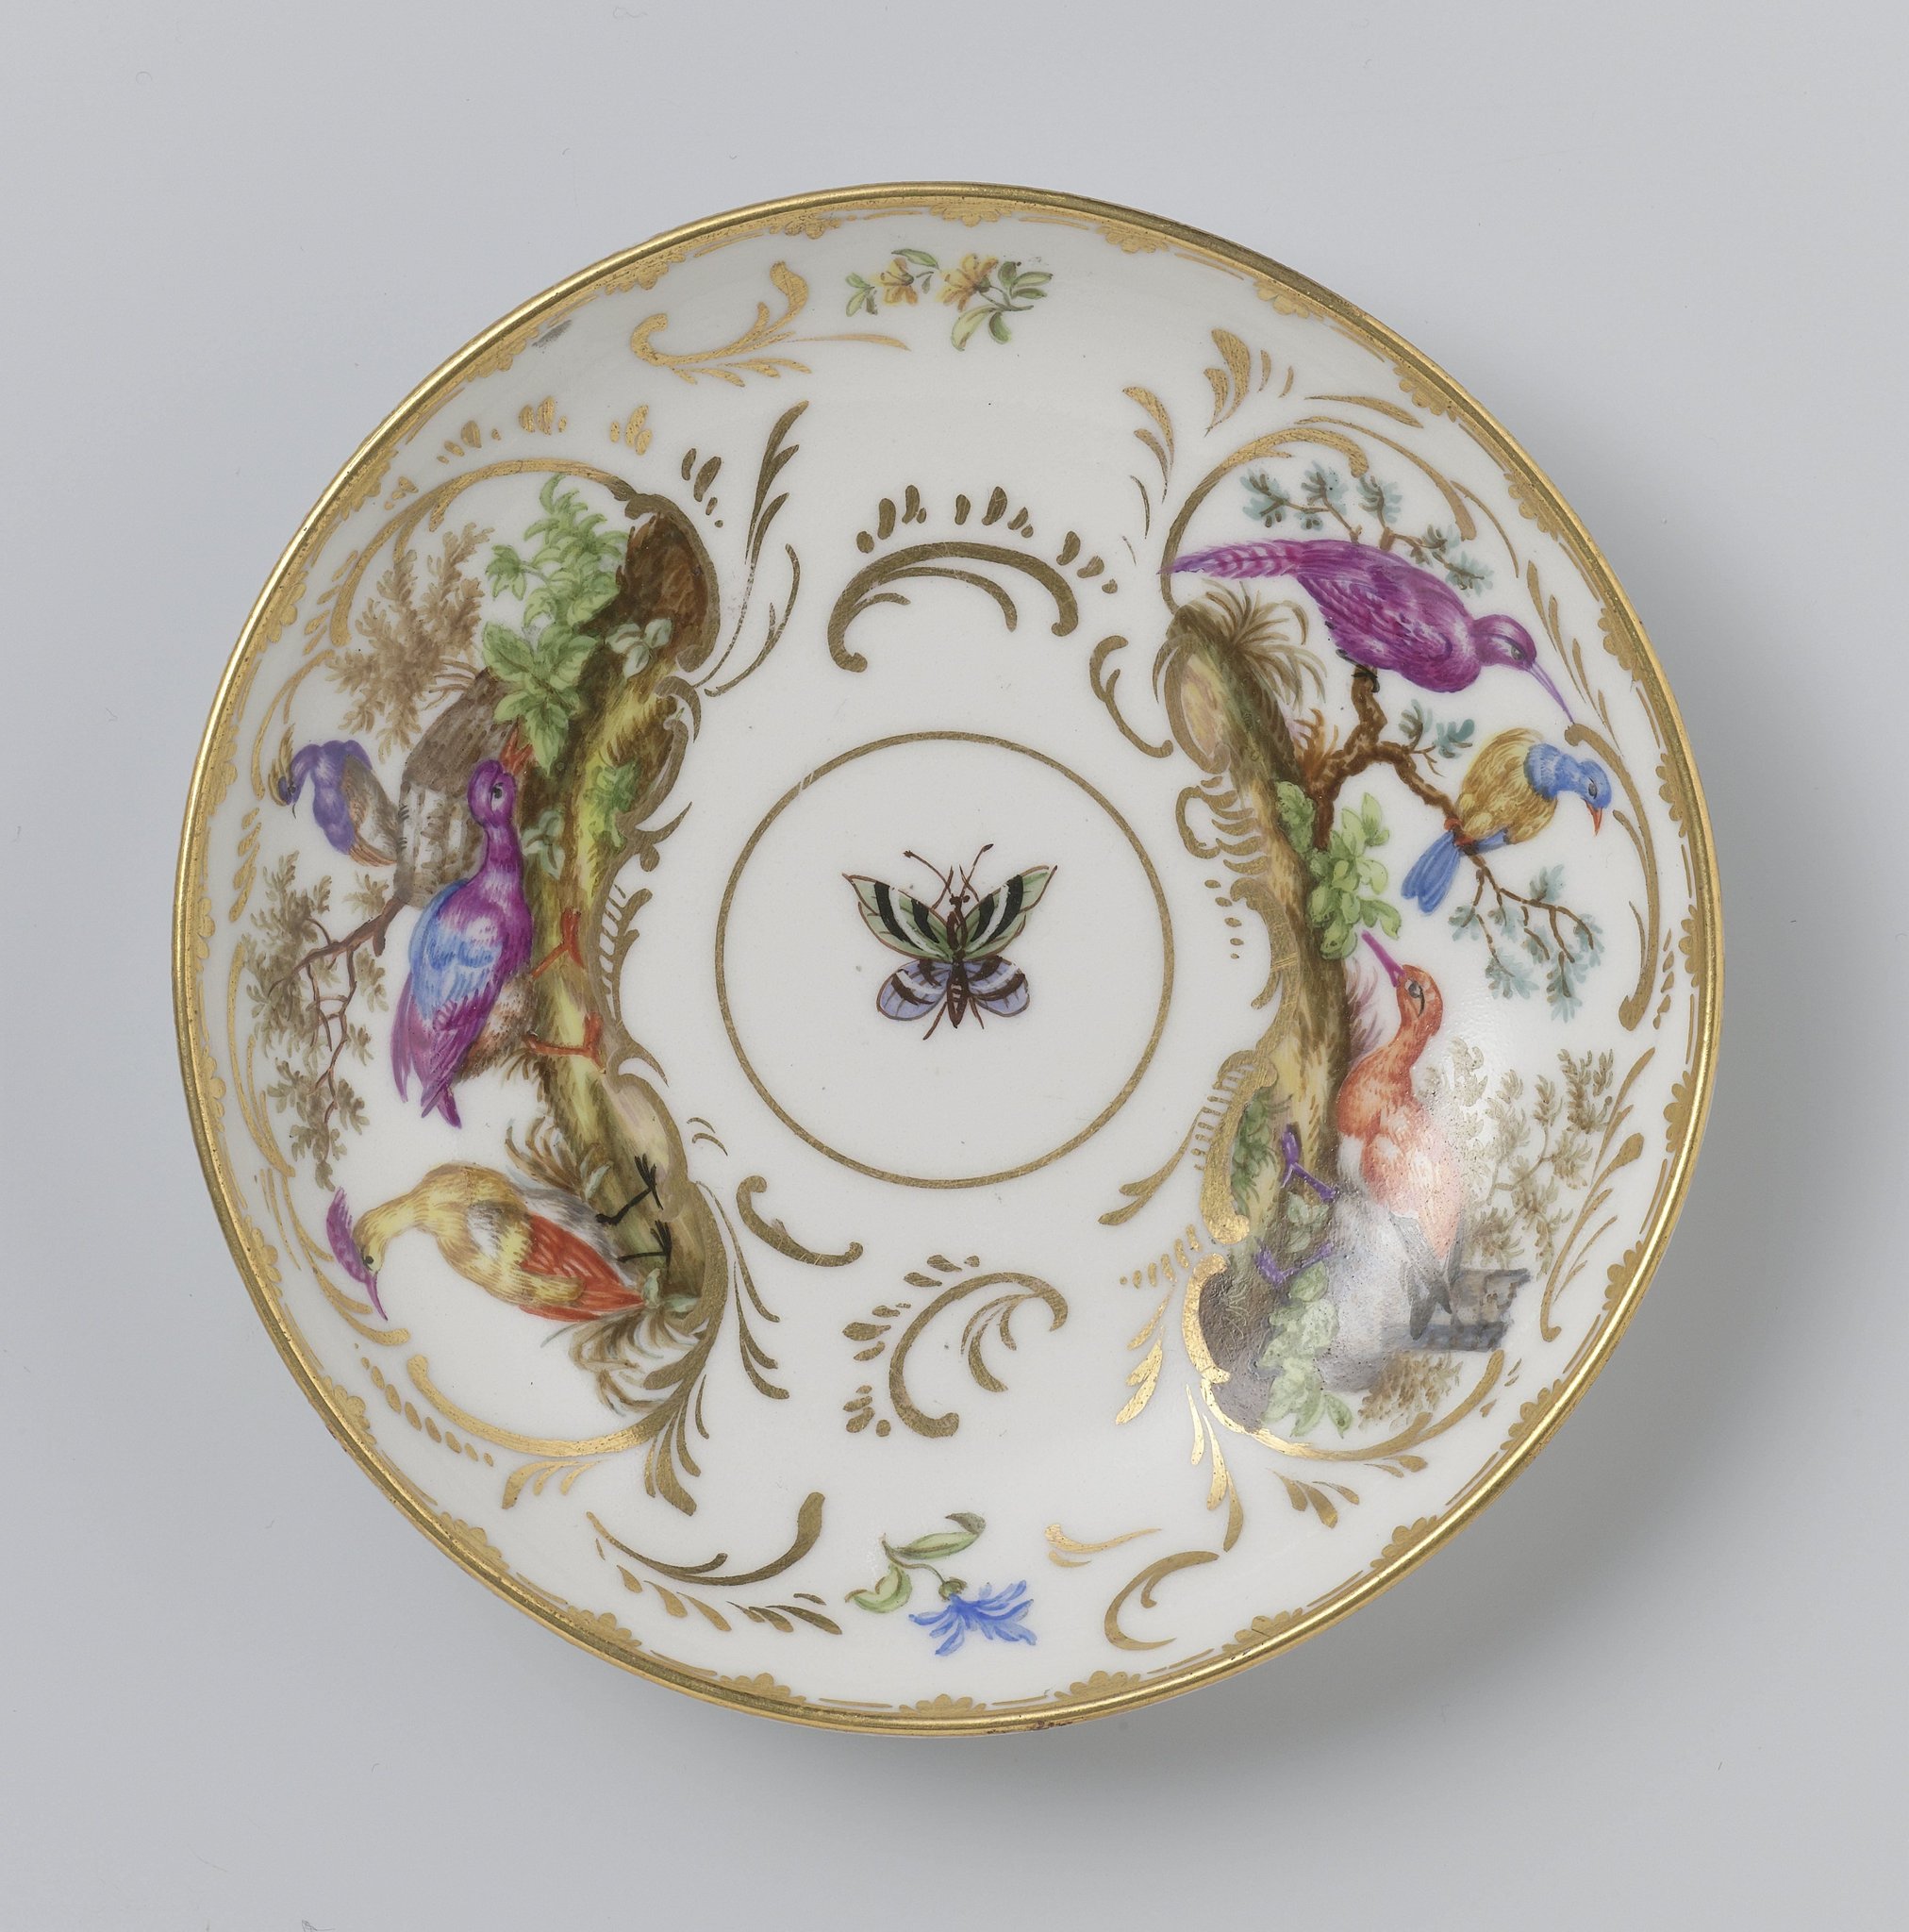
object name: platter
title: Schotel, beschilderd met vogels in een landschap binnen cartouches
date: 1778-1782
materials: porcelain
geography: loosdrecht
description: Tea cup and saucer. Porcelain. Loosdrecht, 1778 - 1782. Factory of Joannes de Mol. Given by the Belport Familien Stiftung, 1983.